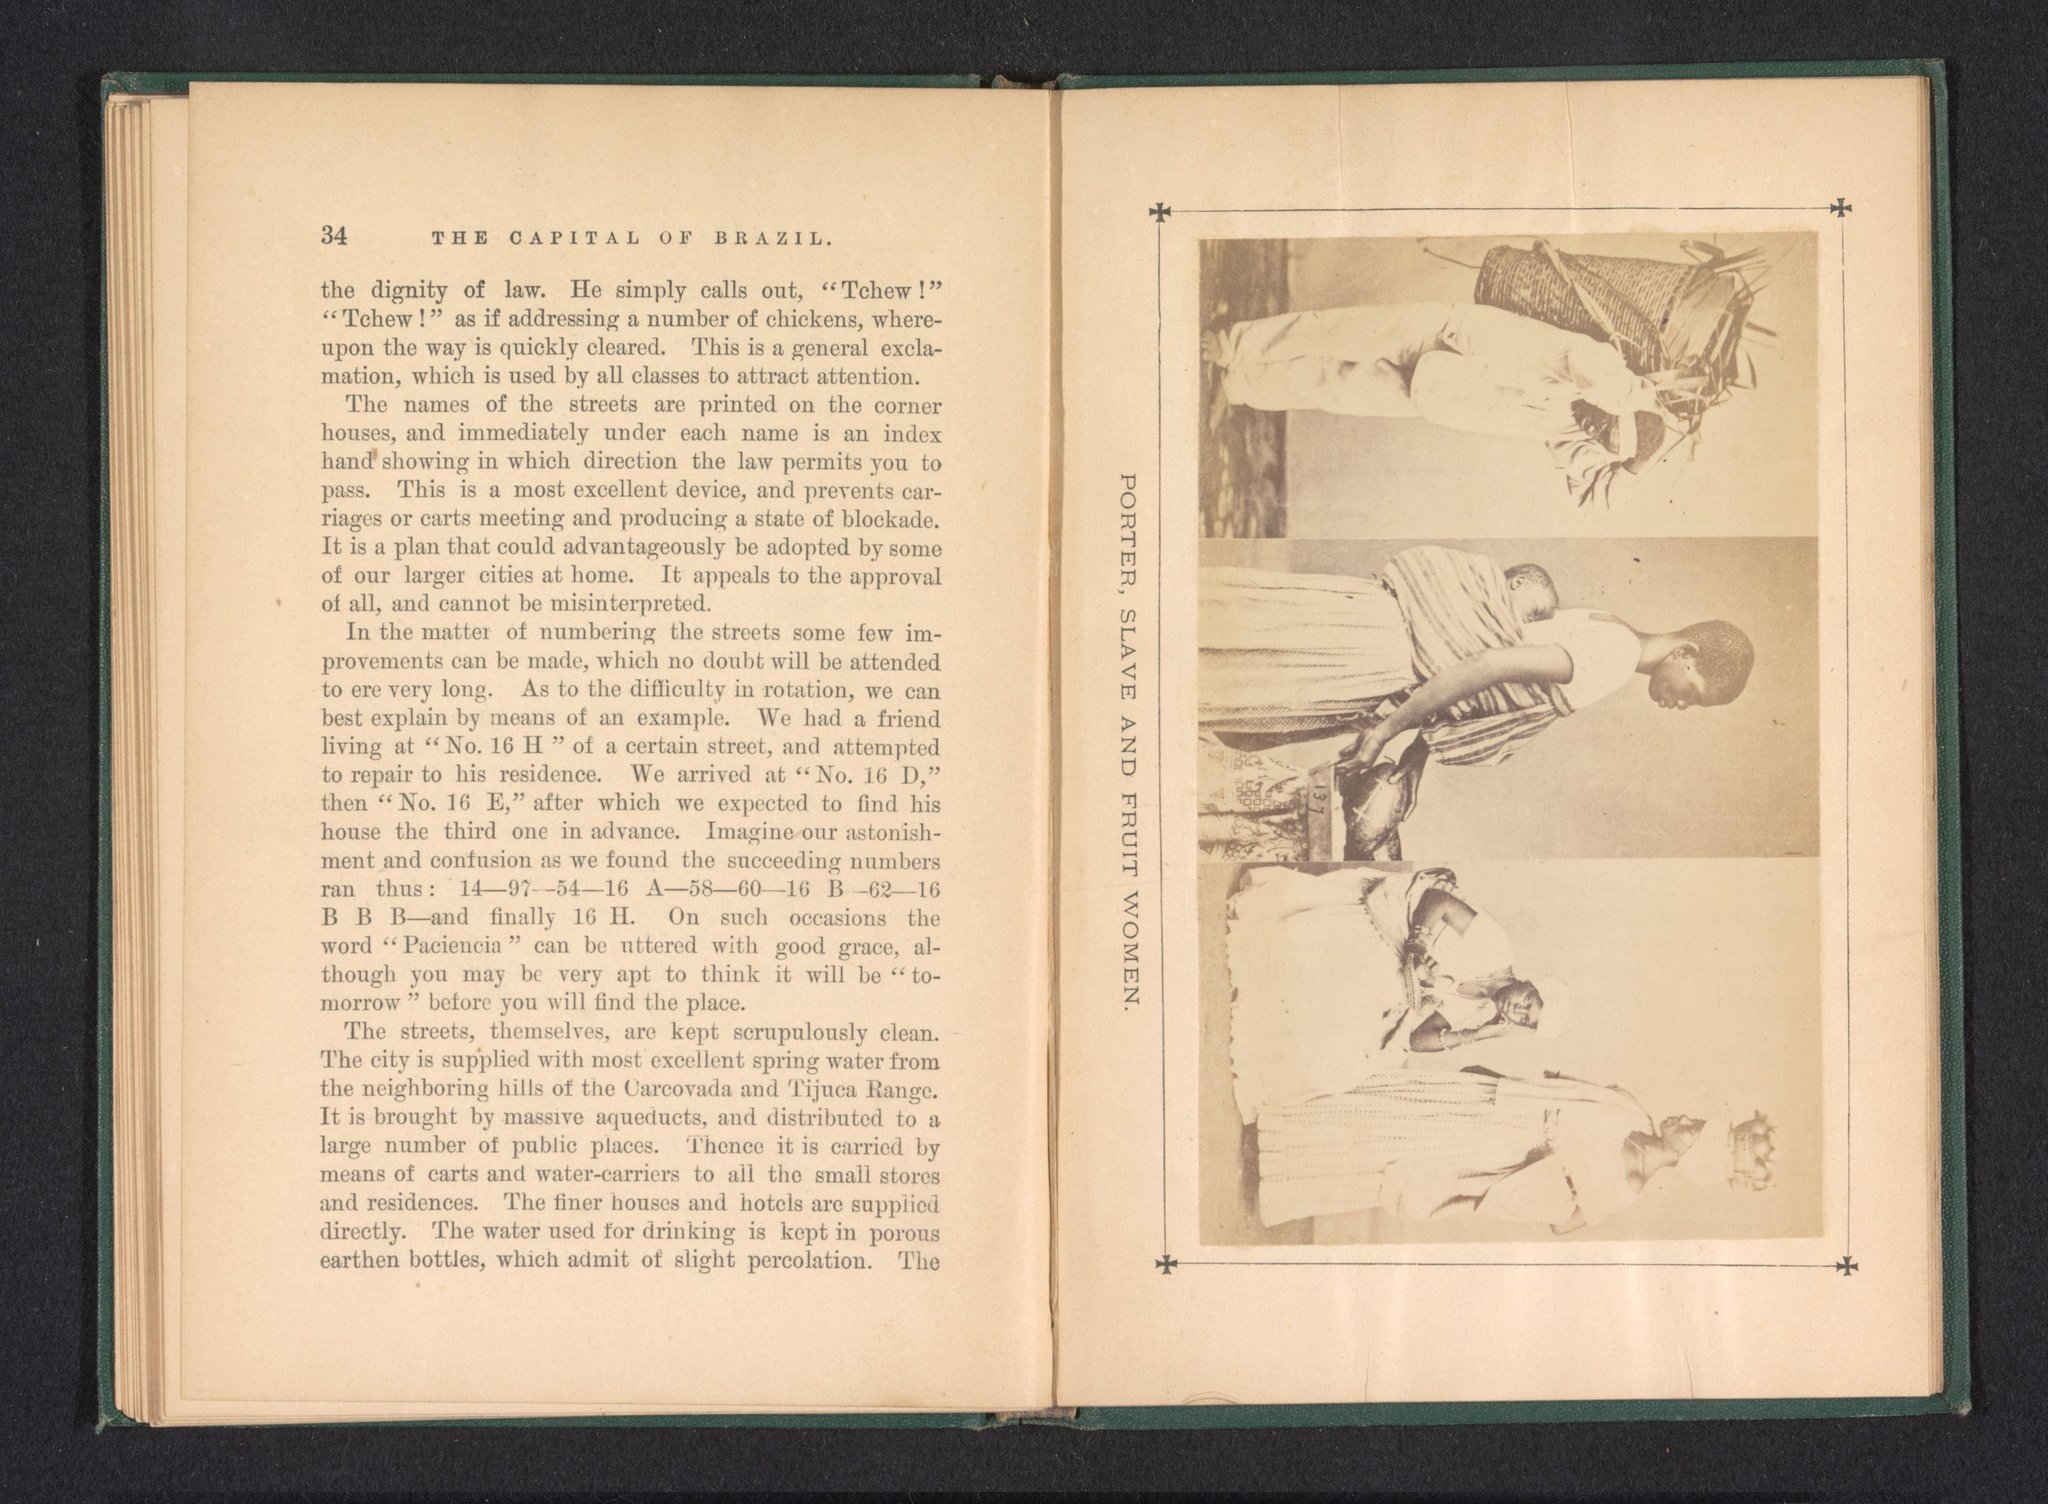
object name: page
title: Porter, slave and fruit women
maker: Anonymous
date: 1864-1874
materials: photographic support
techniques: albumen print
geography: brazil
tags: slavery; serfs and enslaved persons, street-trader, porter, bearer